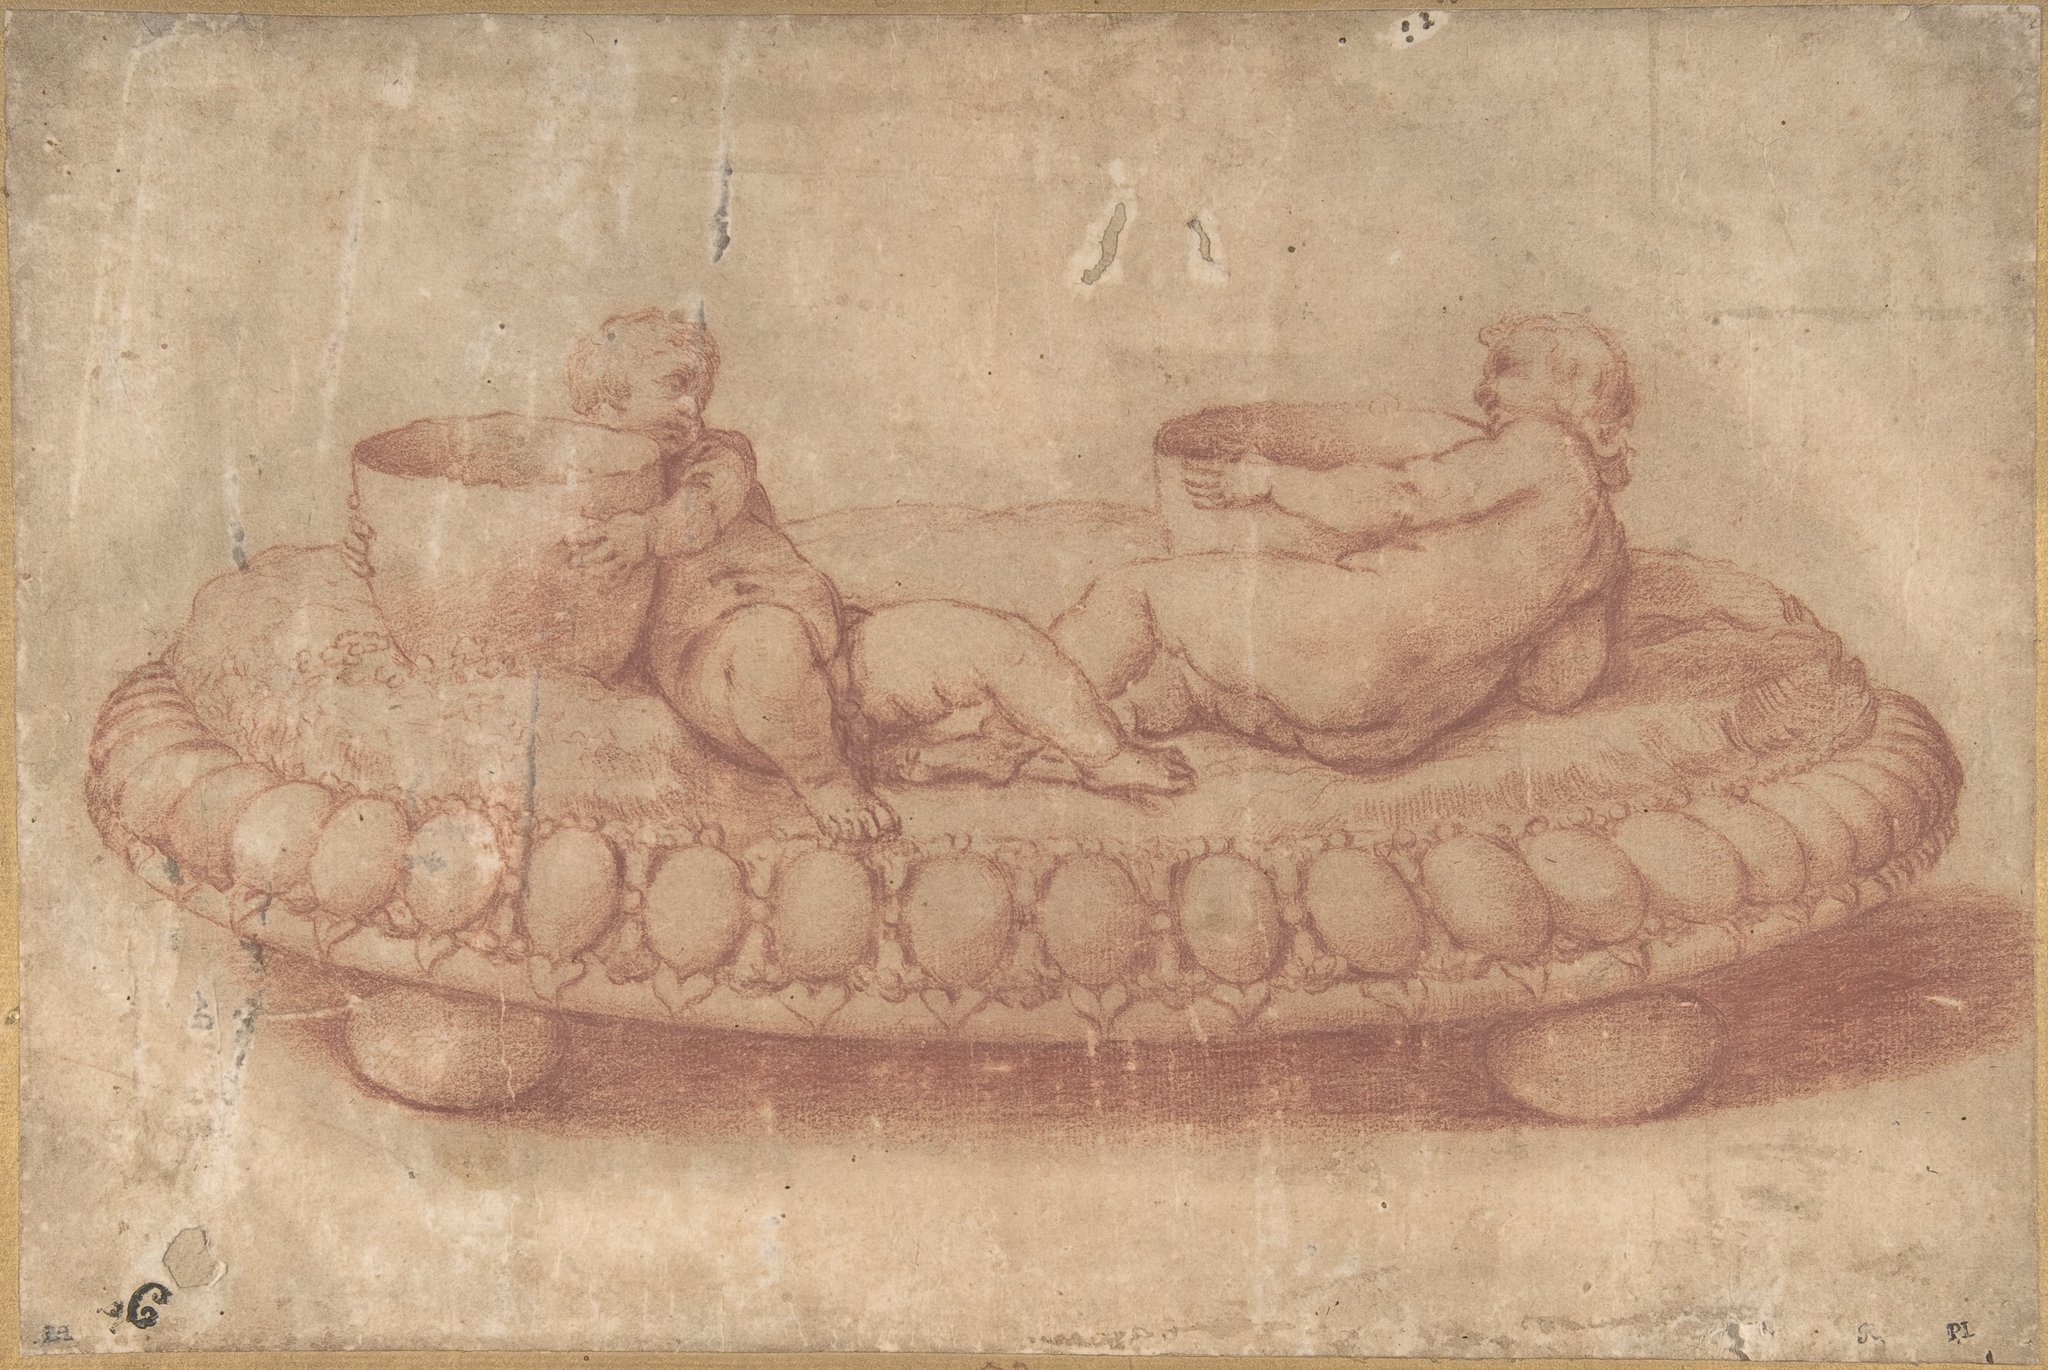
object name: drawing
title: Design for a Saltcellar with Putti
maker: anonymous, italian, 16th century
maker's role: artist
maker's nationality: italian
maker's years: 1500-1600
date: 1501-1600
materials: chalk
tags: putti